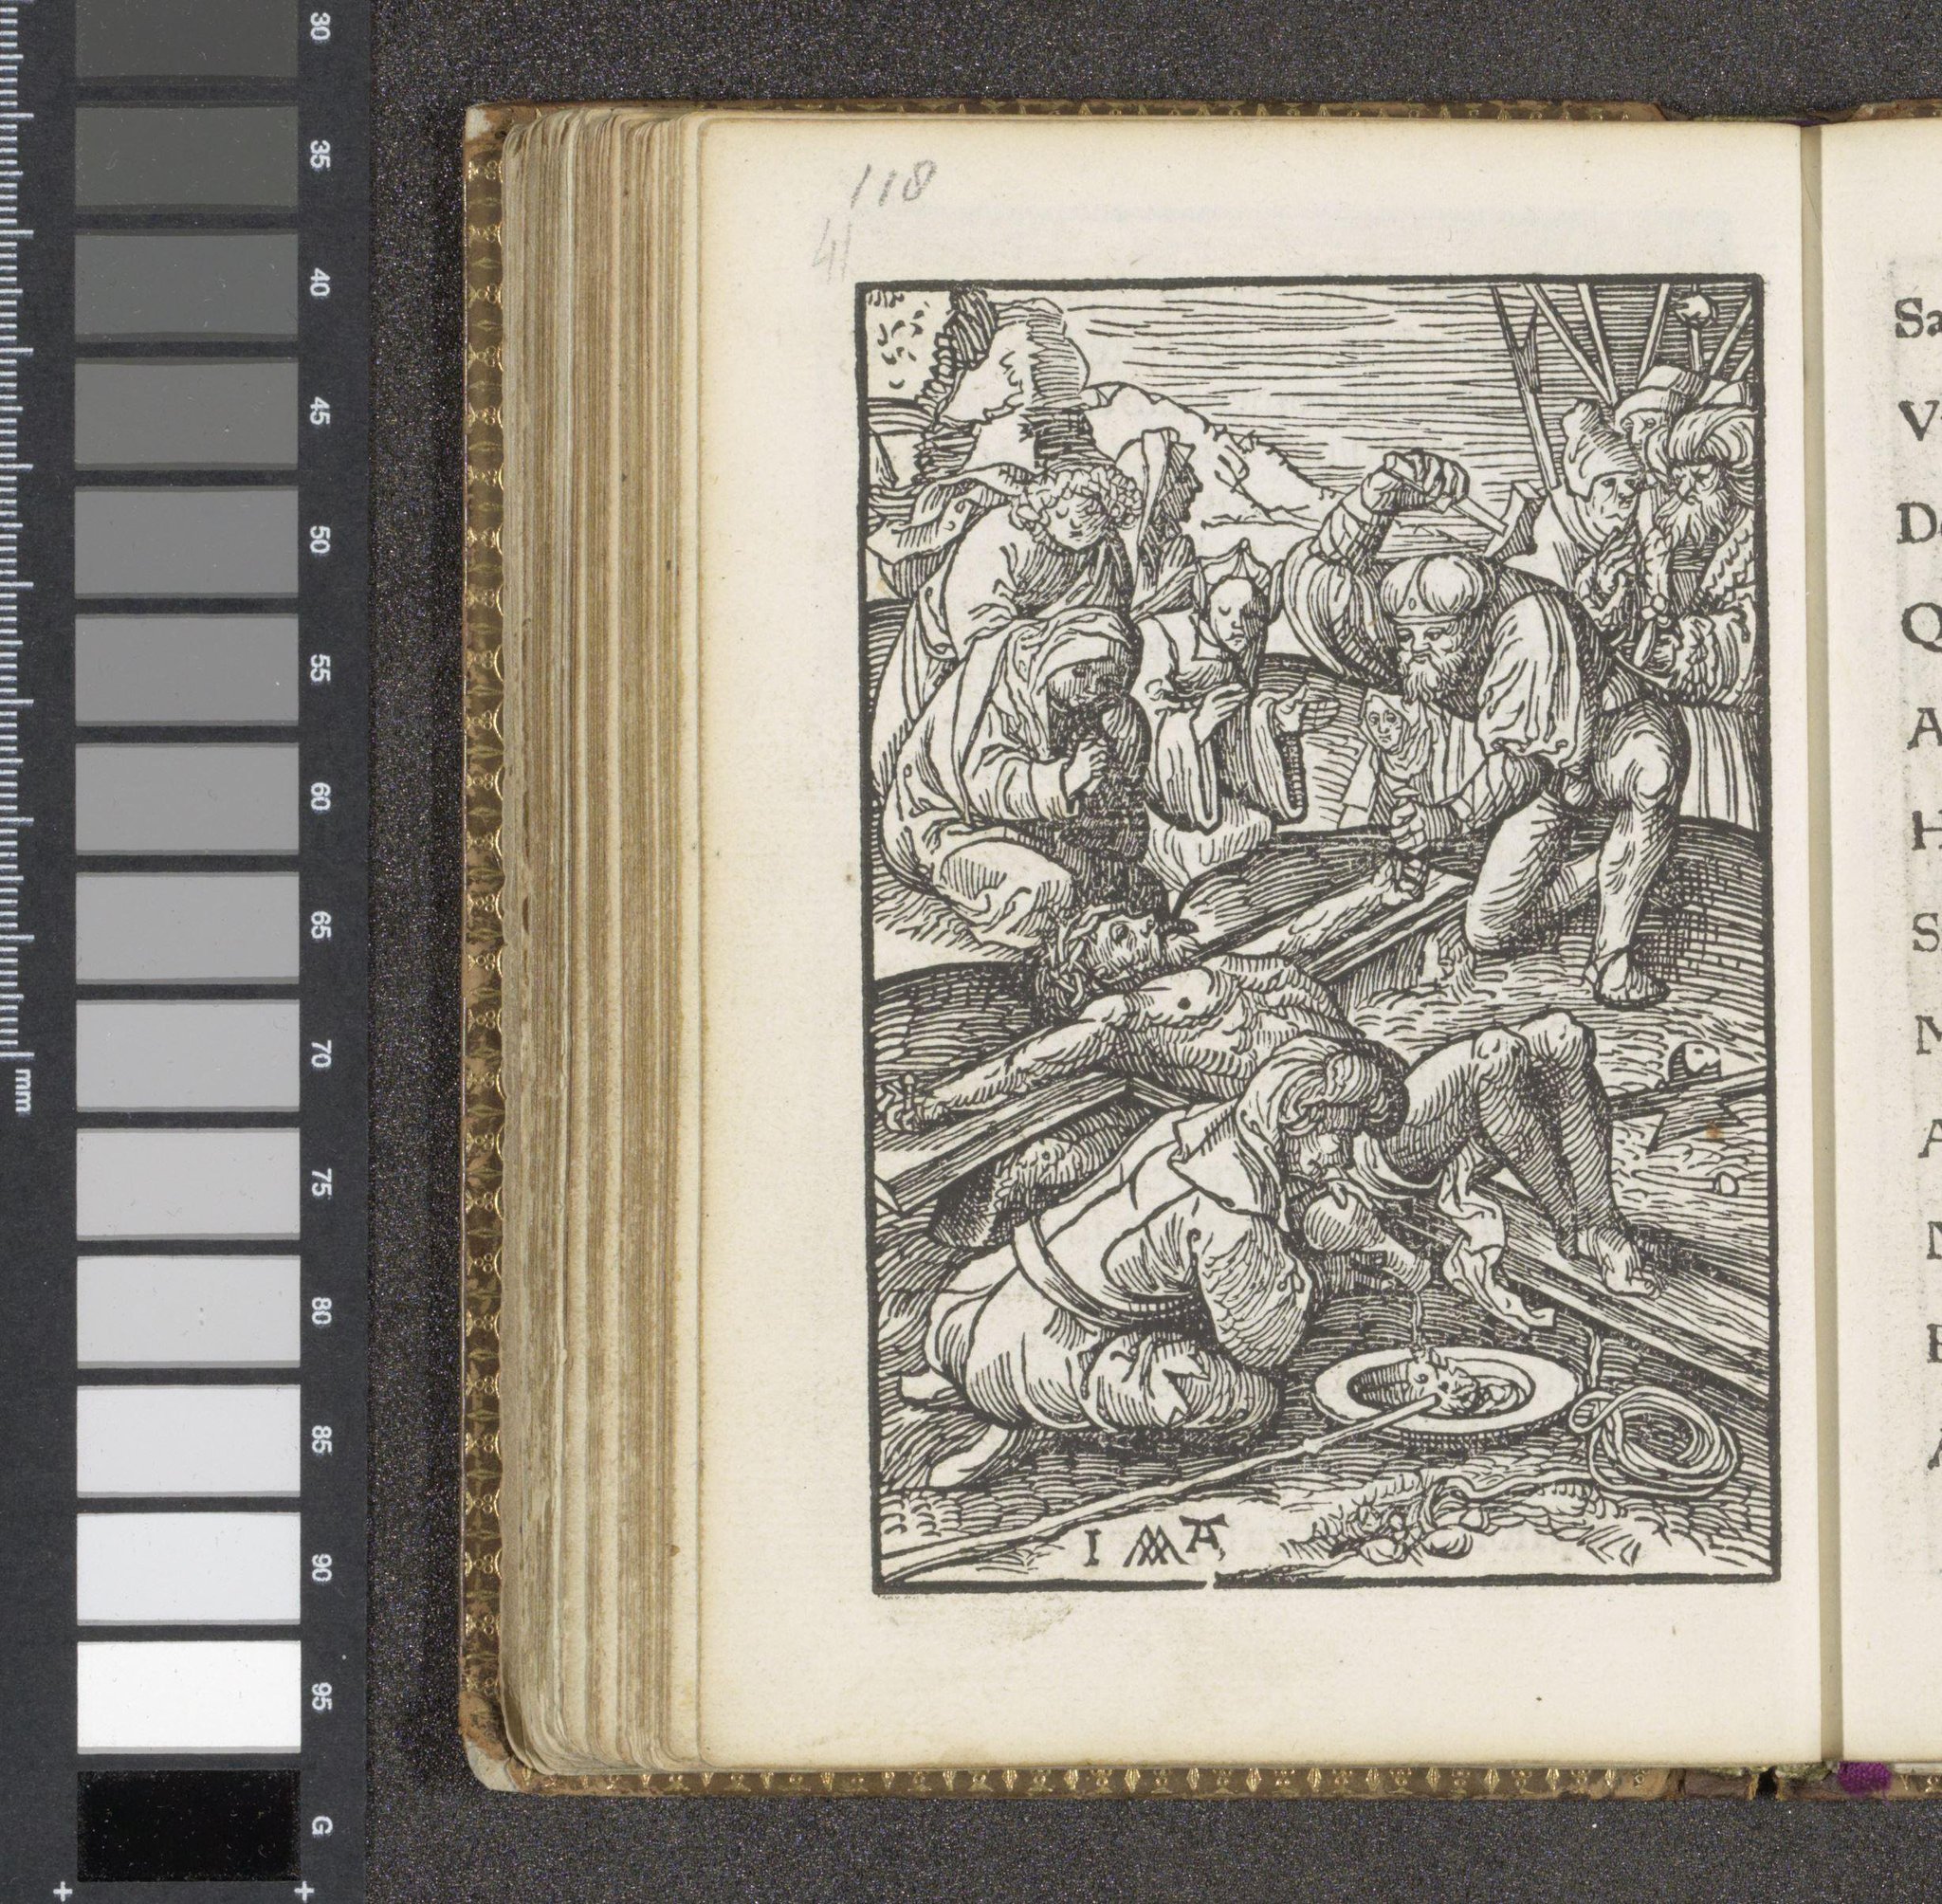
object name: print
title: De kleine Passie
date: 1523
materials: paper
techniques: woodcut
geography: amsterdam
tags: the erection of the cross: christ is nailed to the cross which lies on the ground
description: Christus wordt aan het kruis geslagen. Op de voorgrond giet een man zure wijn in een schaal om daarmee een spons te doordrenken. Maria kijkt toe, ondersteund door Johannes. Prent maakt deel uit van een boek.